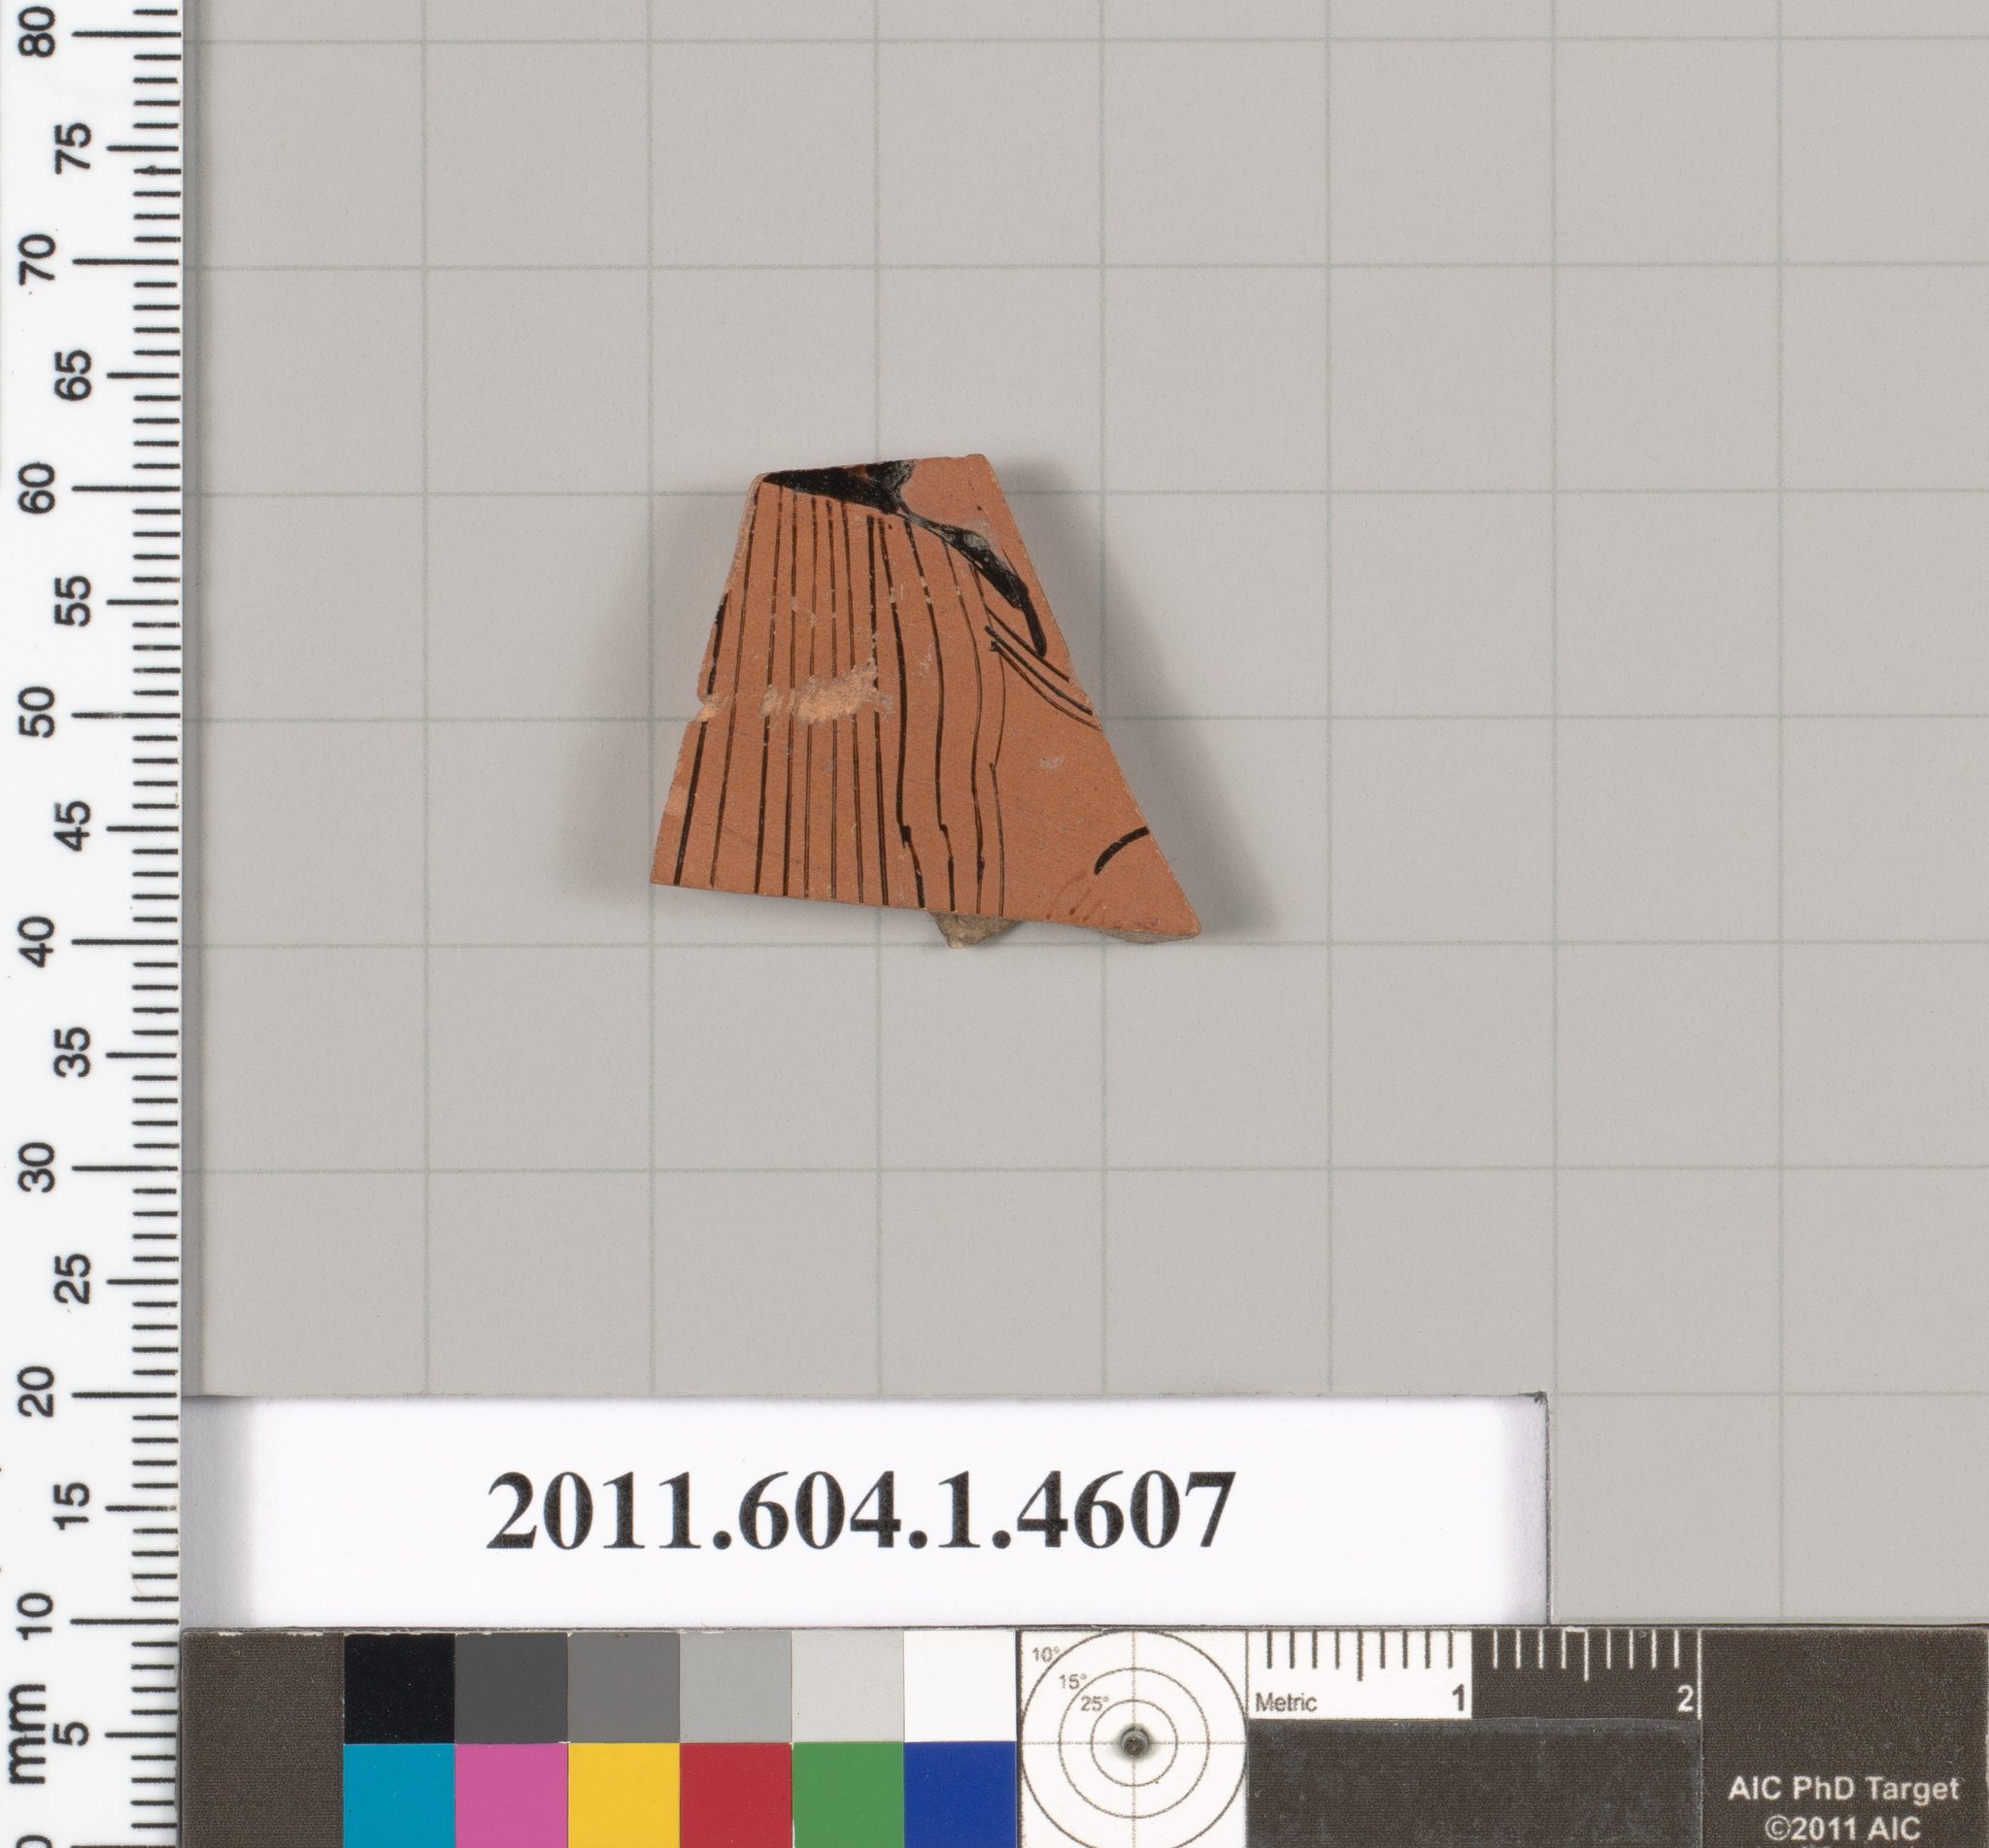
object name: kylix fragment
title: Terracotta fragment of a kylix (drinking cup)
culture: greek, attic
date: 500-480 BCE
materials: terracotta